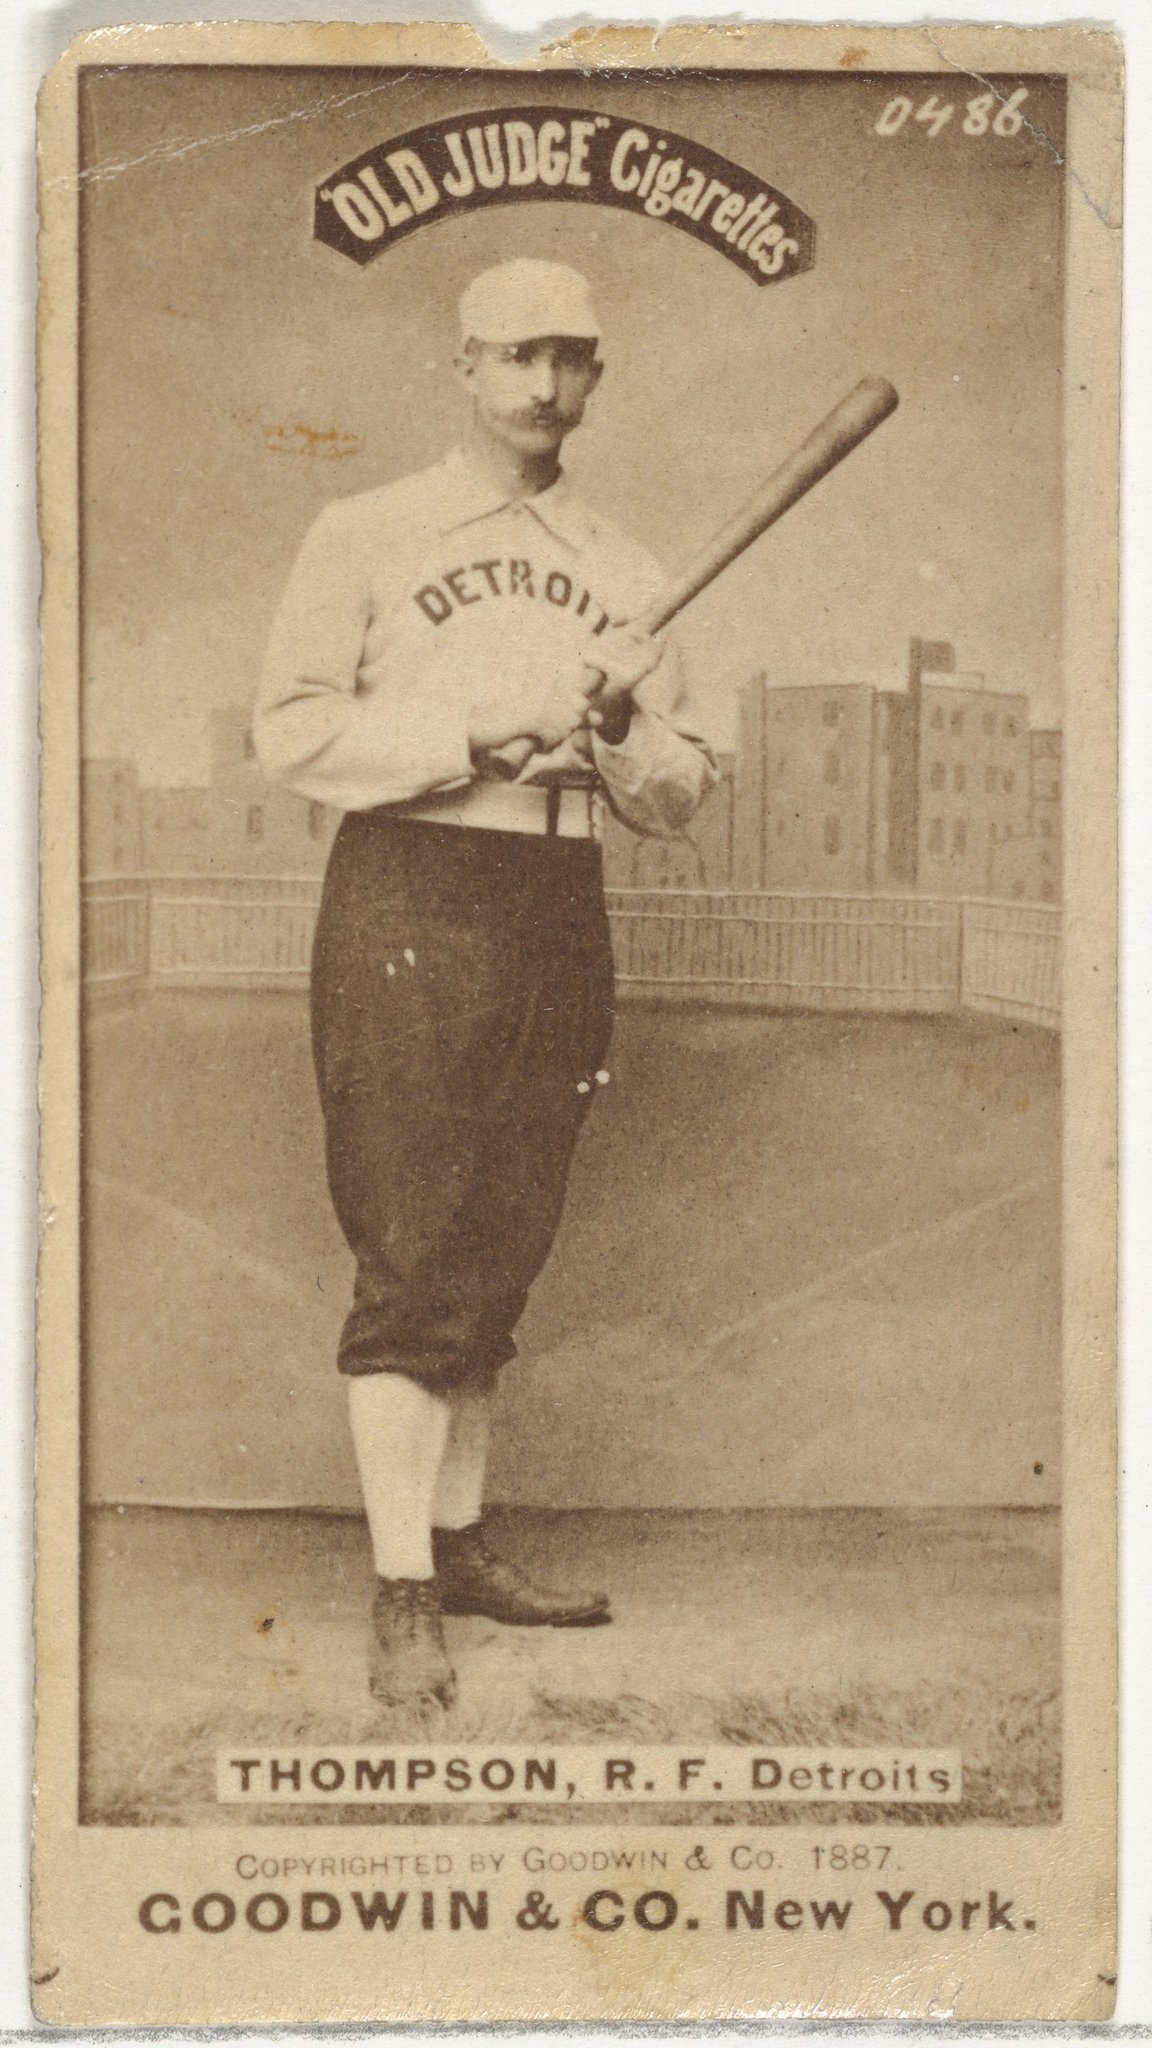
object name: baseball card, photograph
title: Samuel Luther "Sam" Thompson, Right Field, Detroit Wolverines, from the Old Judge series (N172) for Old Judge Cigarettes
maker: goodwin & company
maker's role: publisher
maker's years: 1850-1950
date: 1887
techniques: albumen silver print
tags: men,portraits,baseball,athletes